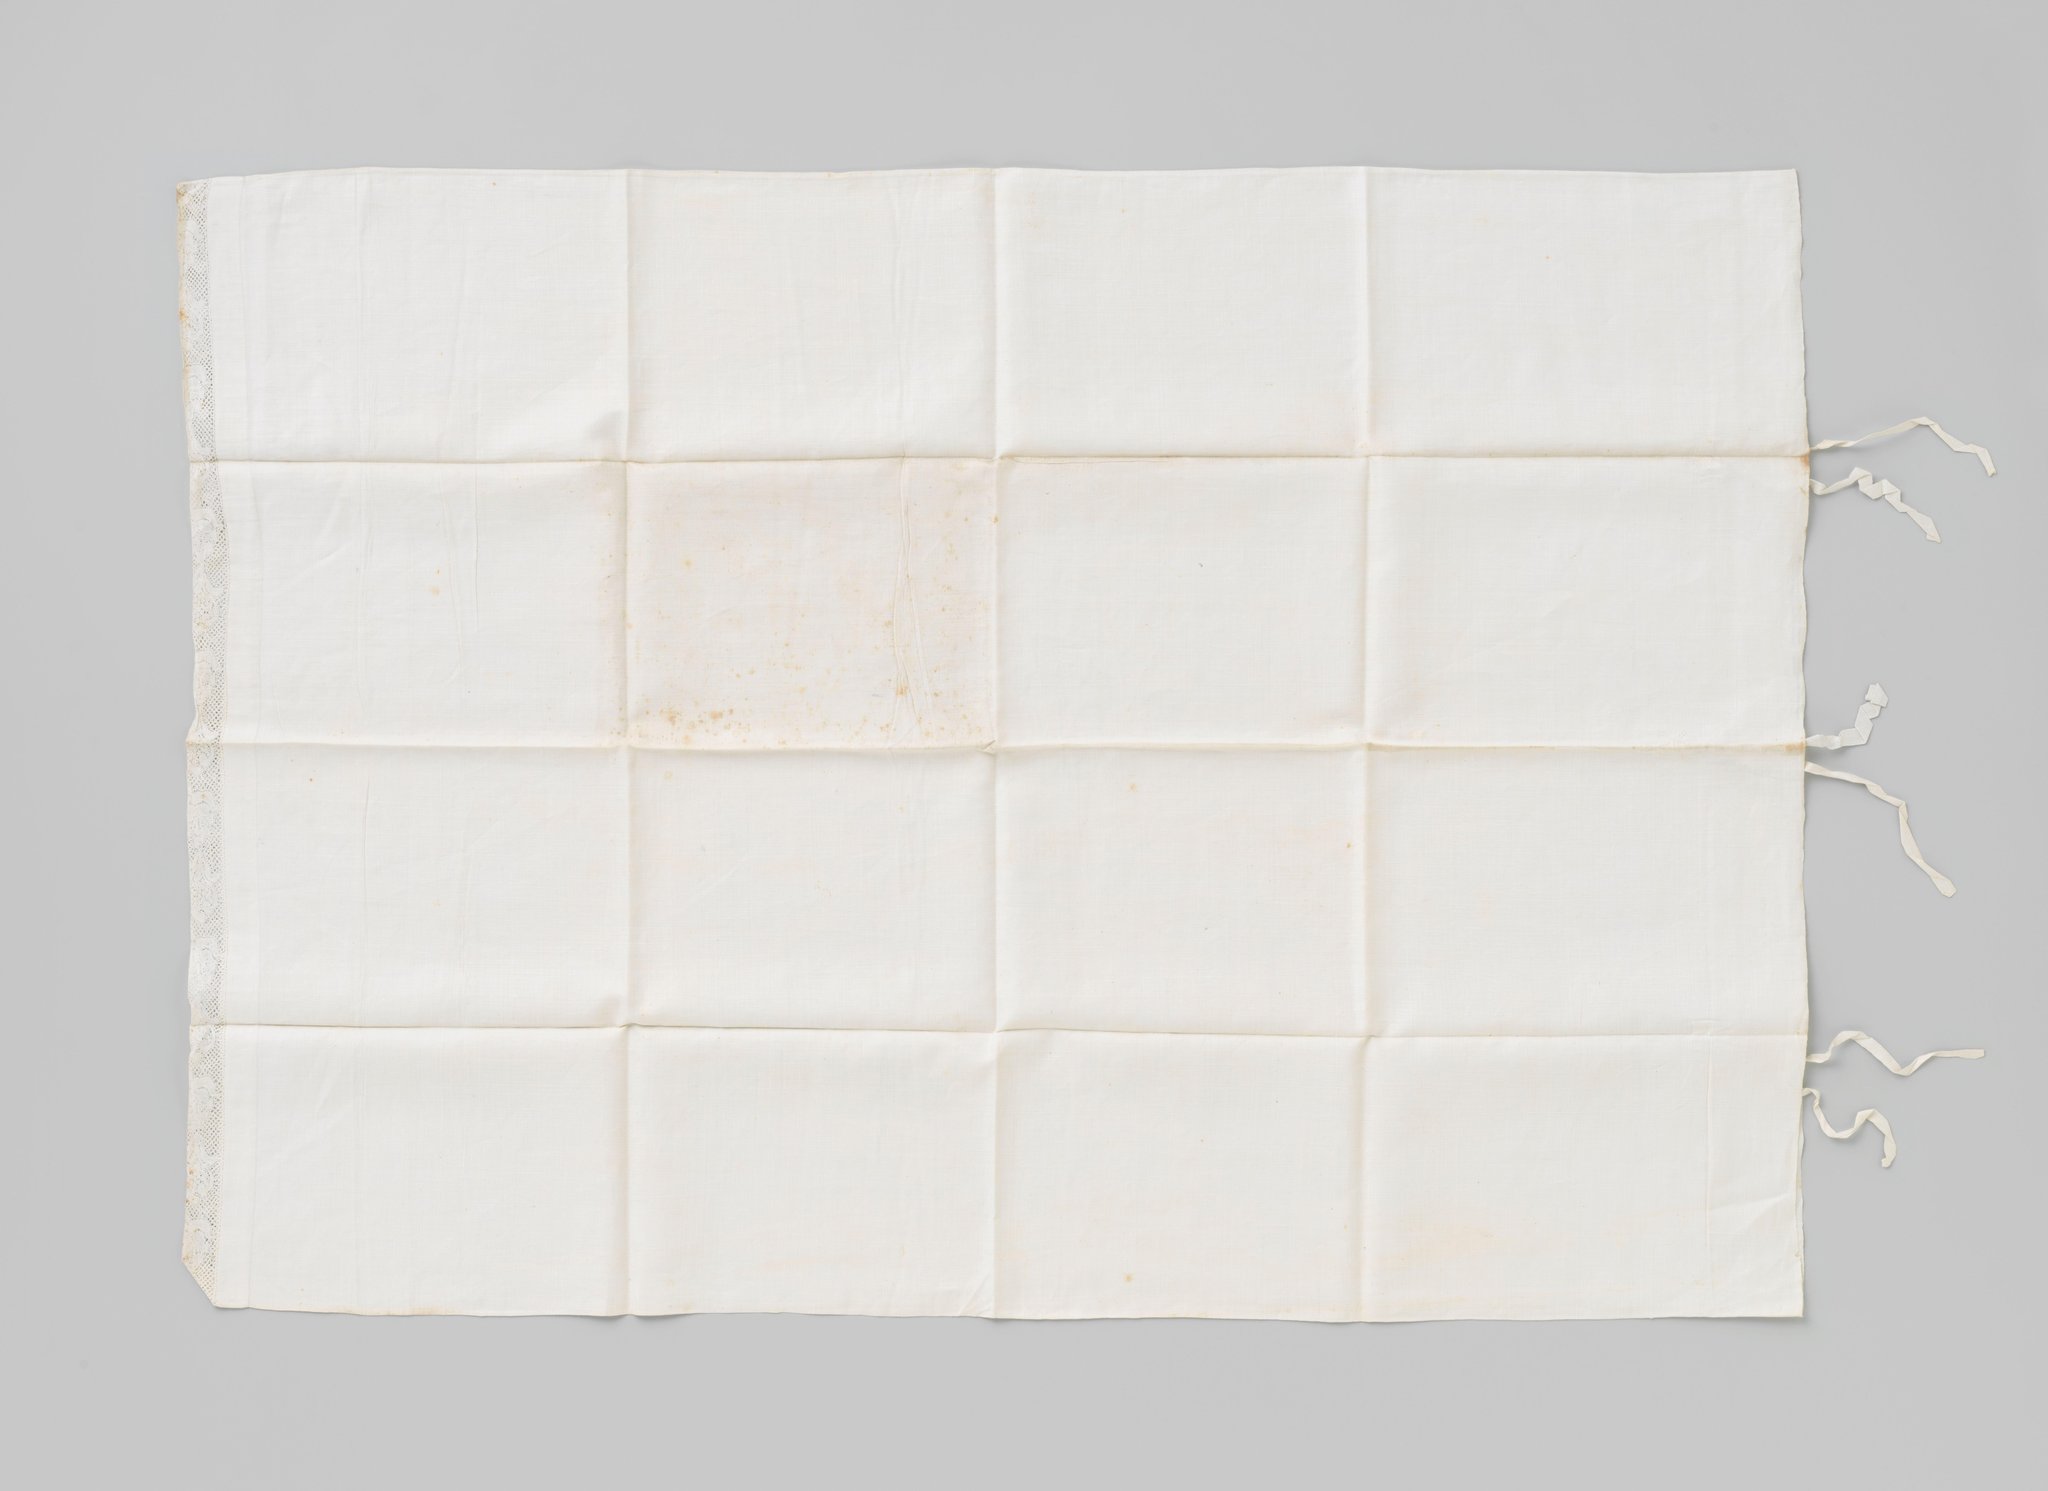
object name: pillowcase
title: Kussensloop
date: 1725-1770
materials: linen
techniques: lace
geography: northern netherlands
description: Kussensloop van linnen met kloskant aan een uiteinde. Gemerkt kroon AVG 4.